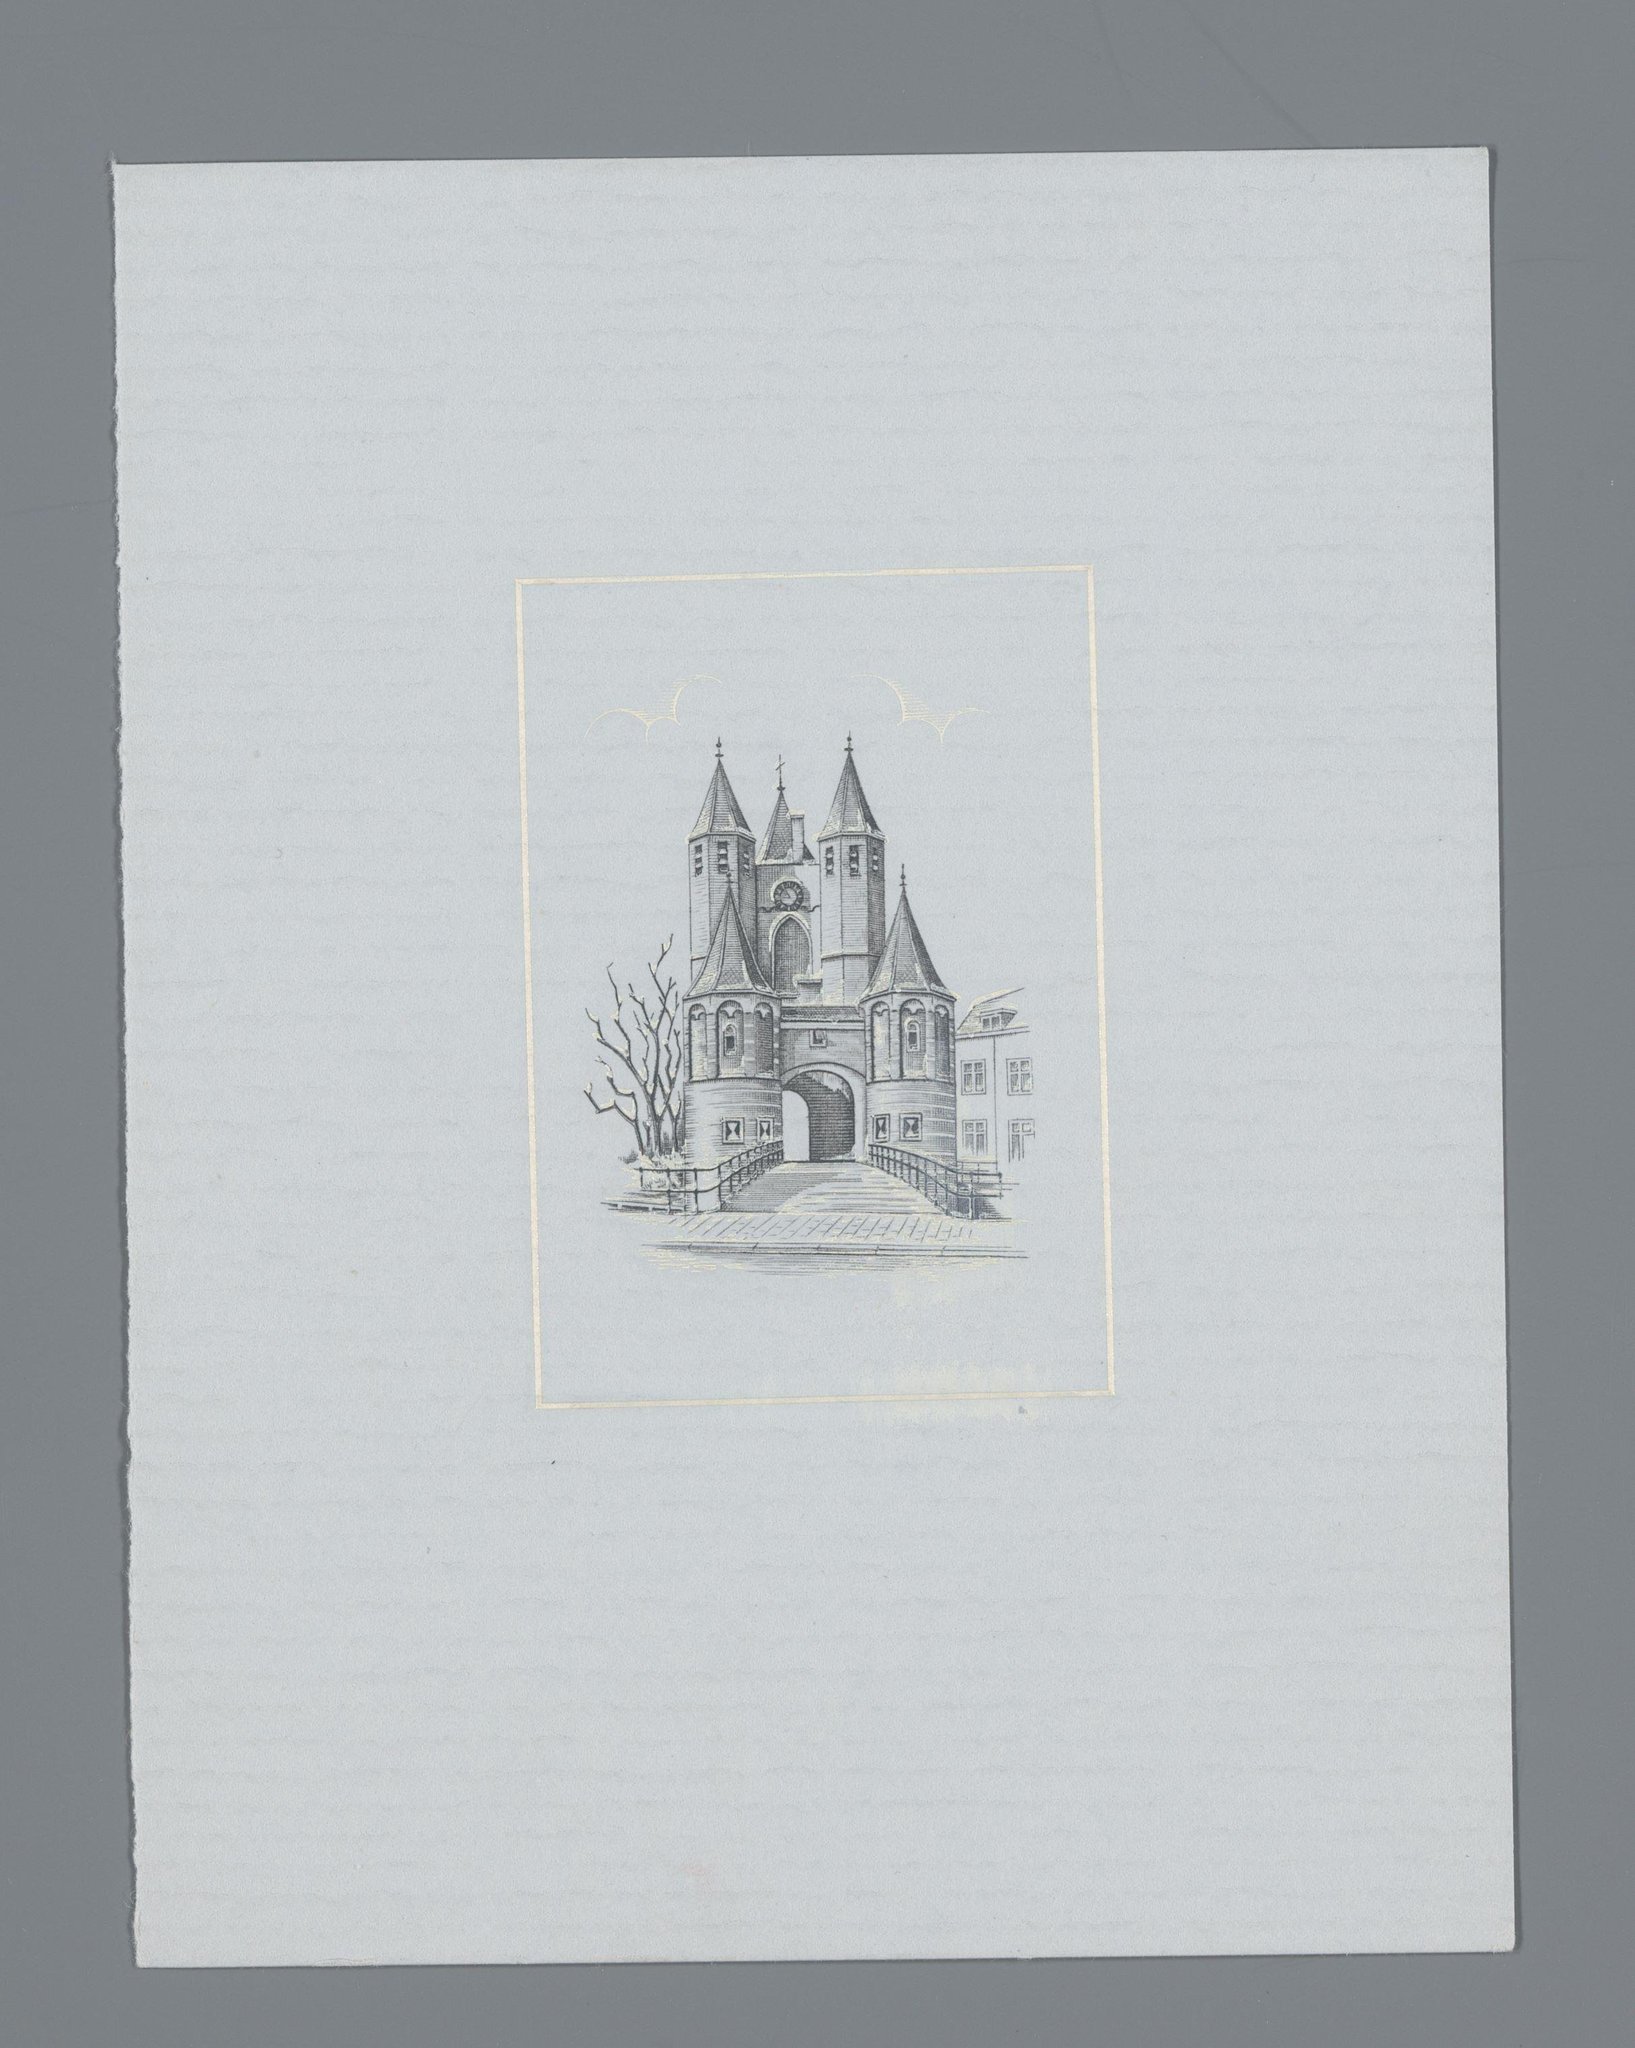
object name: print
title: Gezicht op de Amsterdamse Poort in Haarlem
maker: Anonymous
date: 1900-1999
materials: paper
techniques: etching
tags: city-gate